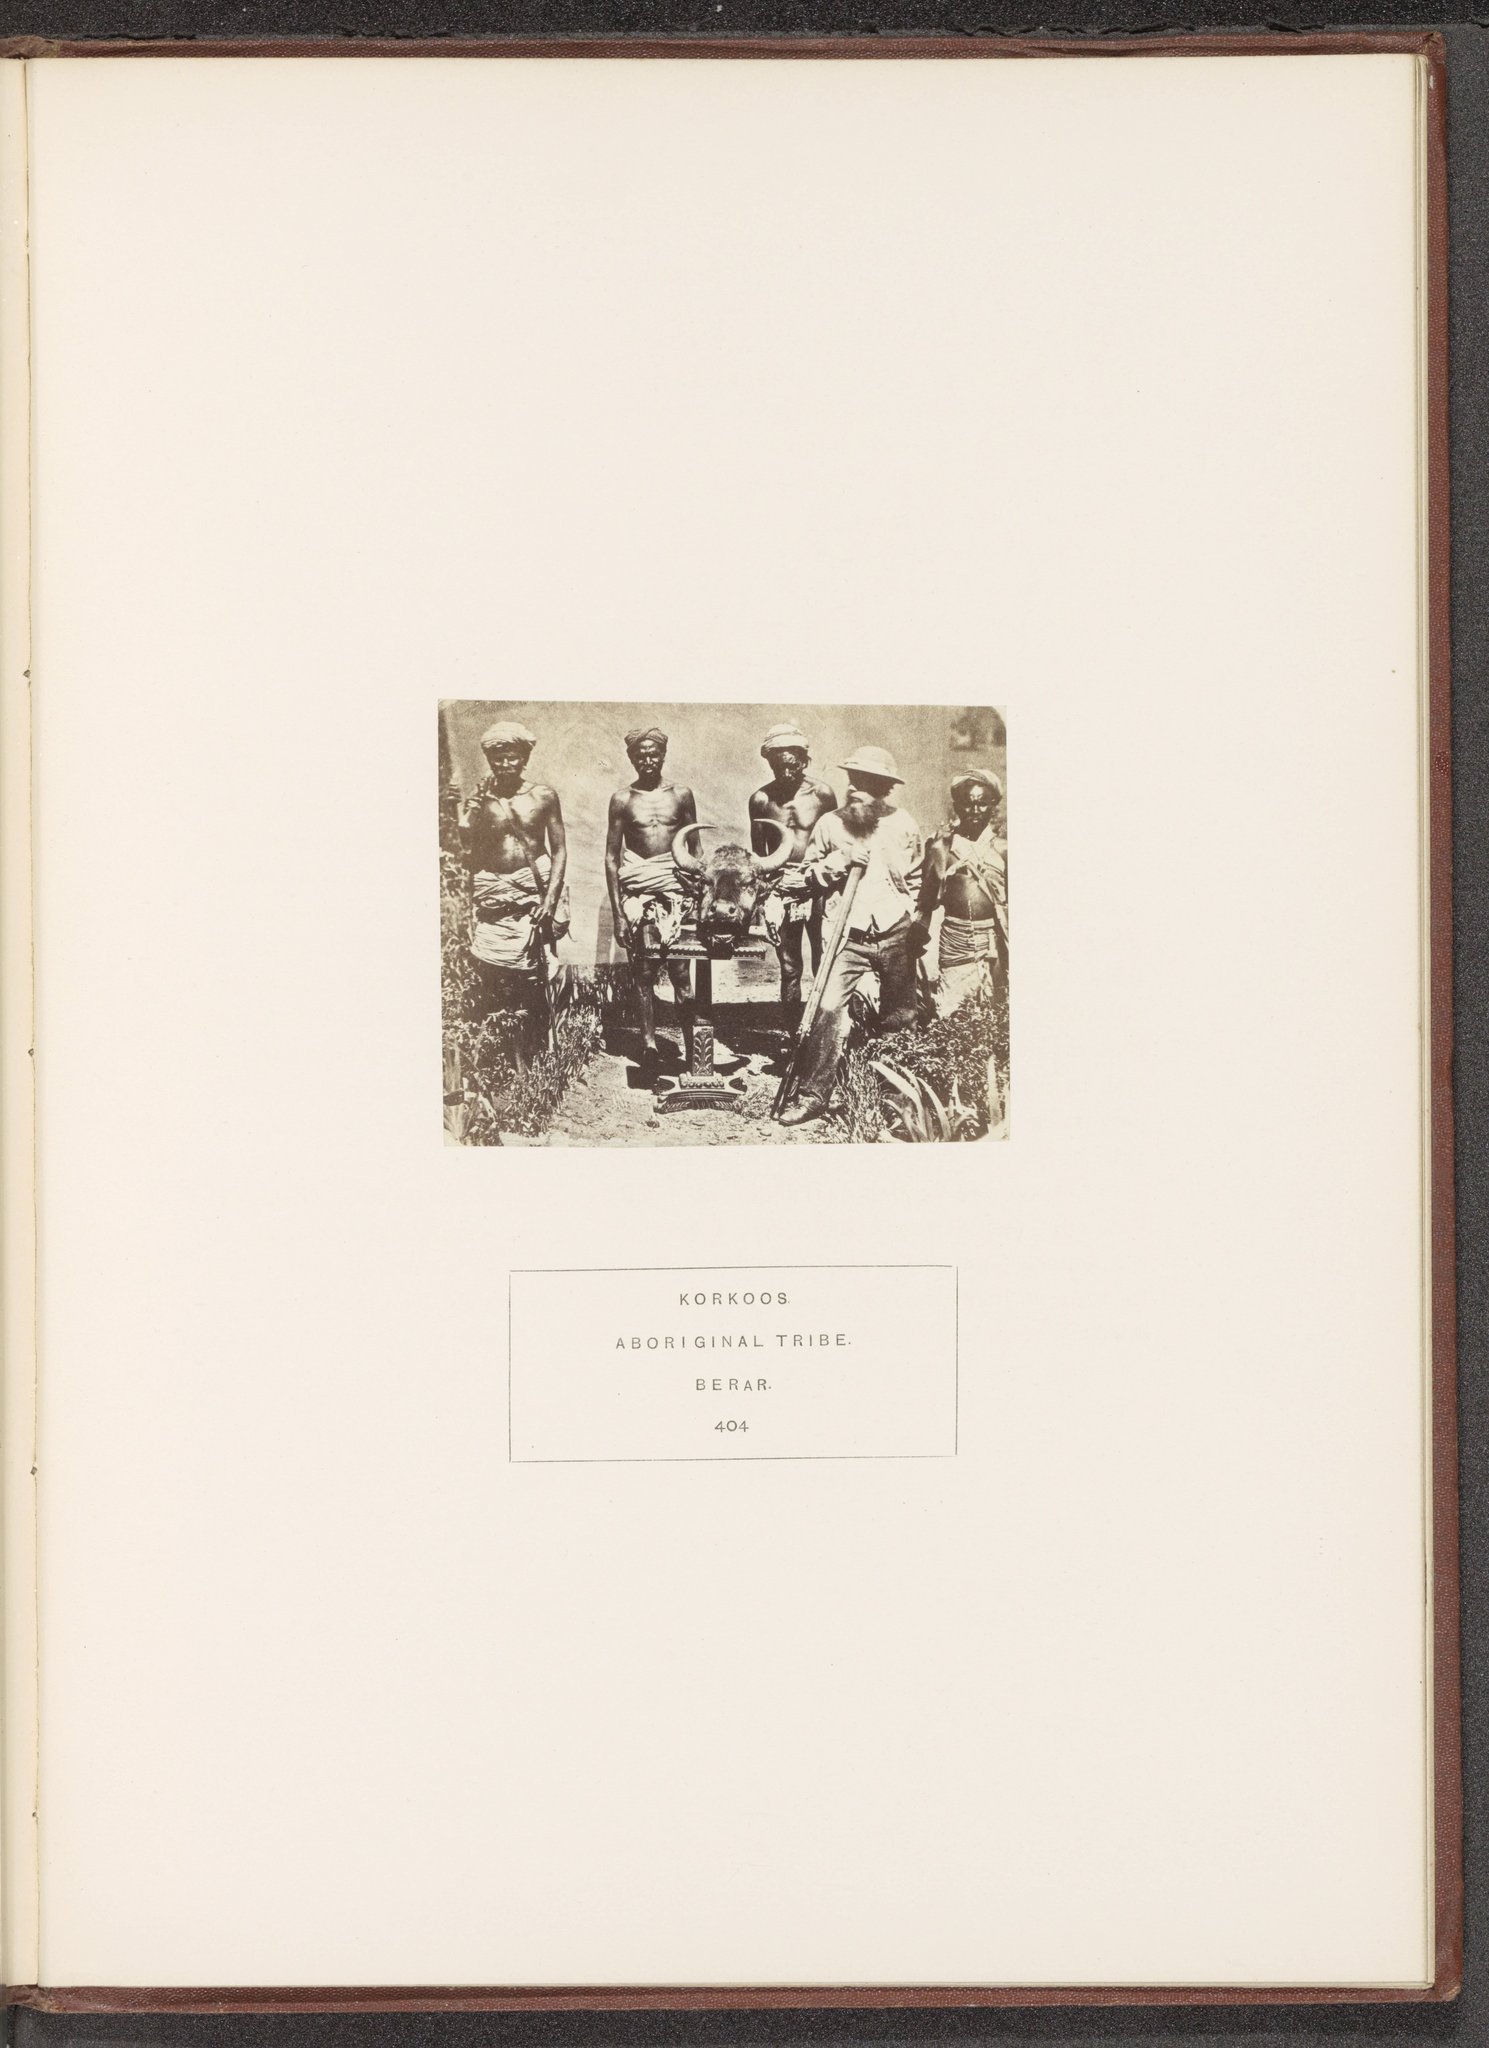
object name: photograph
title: Group of four men from the Korku tribe and a British hunter around a table with a head of bison on it in the former Berar in central India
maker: james mulheran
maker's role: fotograaf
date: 1862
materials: photographic support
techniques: albumen print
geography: berar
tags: hunter, human races; peoples; nationalities, hoofed animals: bison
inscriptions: number: ‘404’, inscription: ‘KORKOOS./ ABORIGINAL TRIBE./ BERAR.’